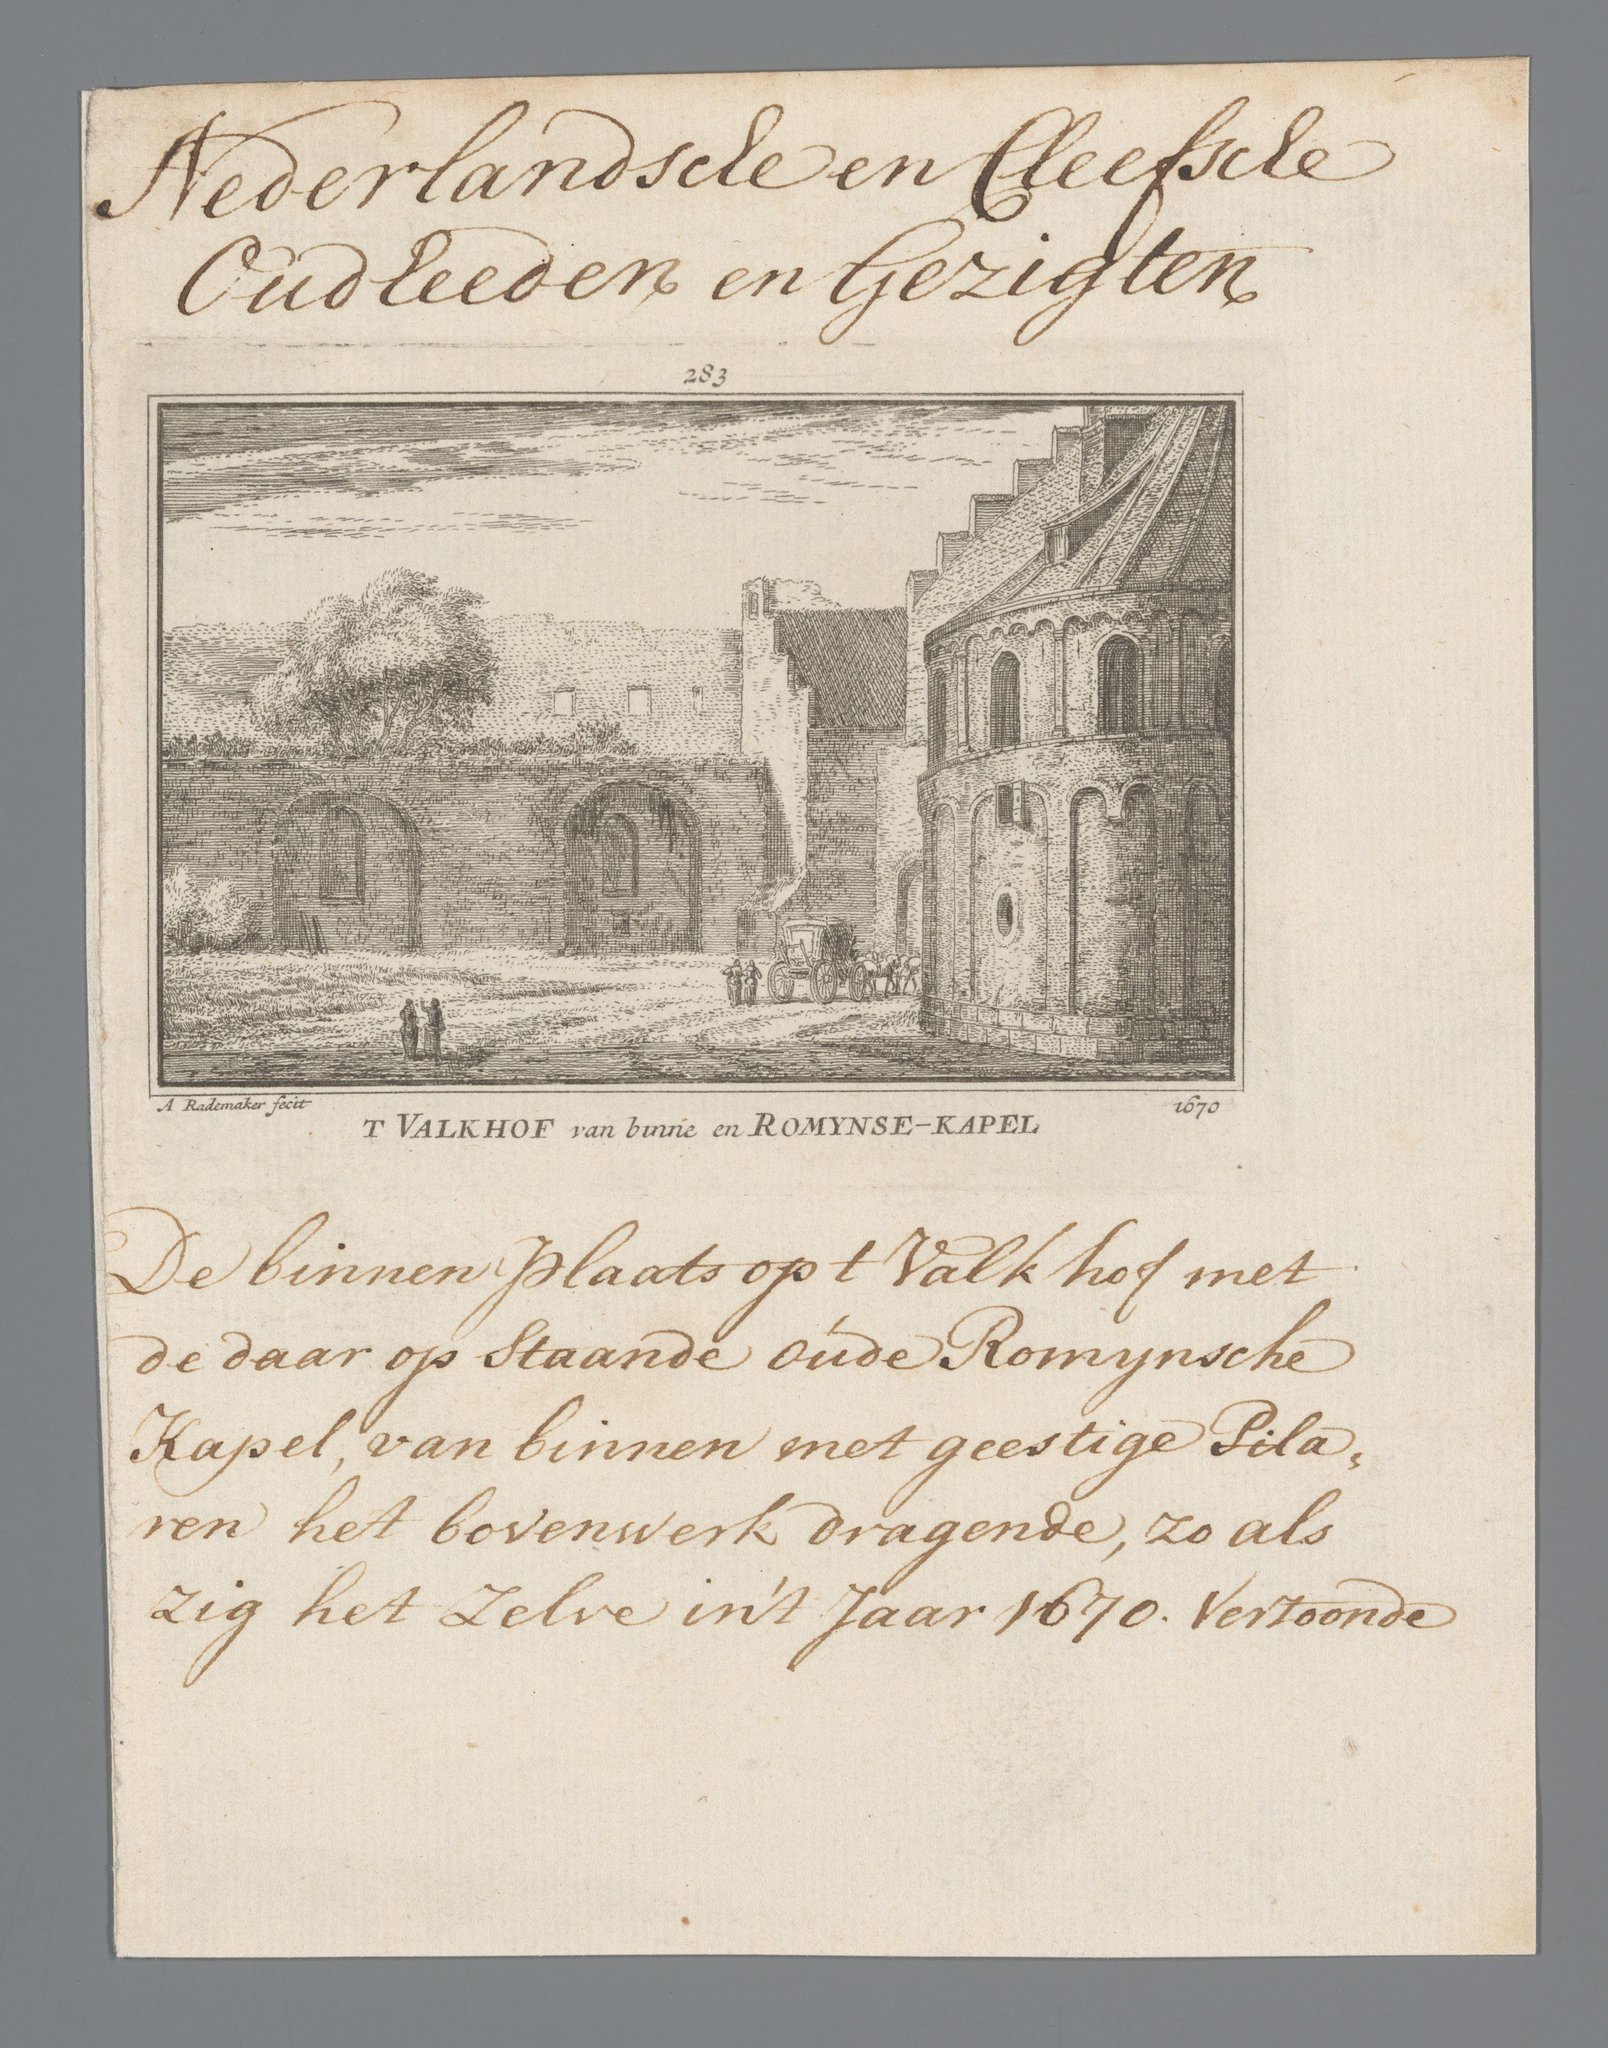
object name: book illustration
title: Gezicht op het Valkhof en de Sint Maartenskapel of Barbarossa-ruïne te Nijmegen, 1670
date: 1725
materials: ink, paper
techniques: etching, pen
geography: amsterdam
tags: church (exterior) - qq - small church, chapel, ruin of a dwelling, house, castle, etc.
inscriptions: inscription: ‘Nederlandsche en Cleefsche Oudheden en Gezigten De binnenplaats op 't Valkhof met de daar op staande oude Romynsche Kapel, van binnen met geestige Pilaren het bovenwerk dragende, zo als zig het zelve in 't jaar 1670 vertoonde’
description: Prent voor het eerst gebruikt in: Rademaker, Abraham. Kabinet van Nederlandsche outheden en gezichten: vervat in 300 konstplaaten (…). 2 dln. Amsterdam: Willem Barents, 1725, ill. 283. Daarna is de prent in verschillende heruitgaven verschenen, uitgegeven in 1727-1733, 1770-1771 en 1792-1803.